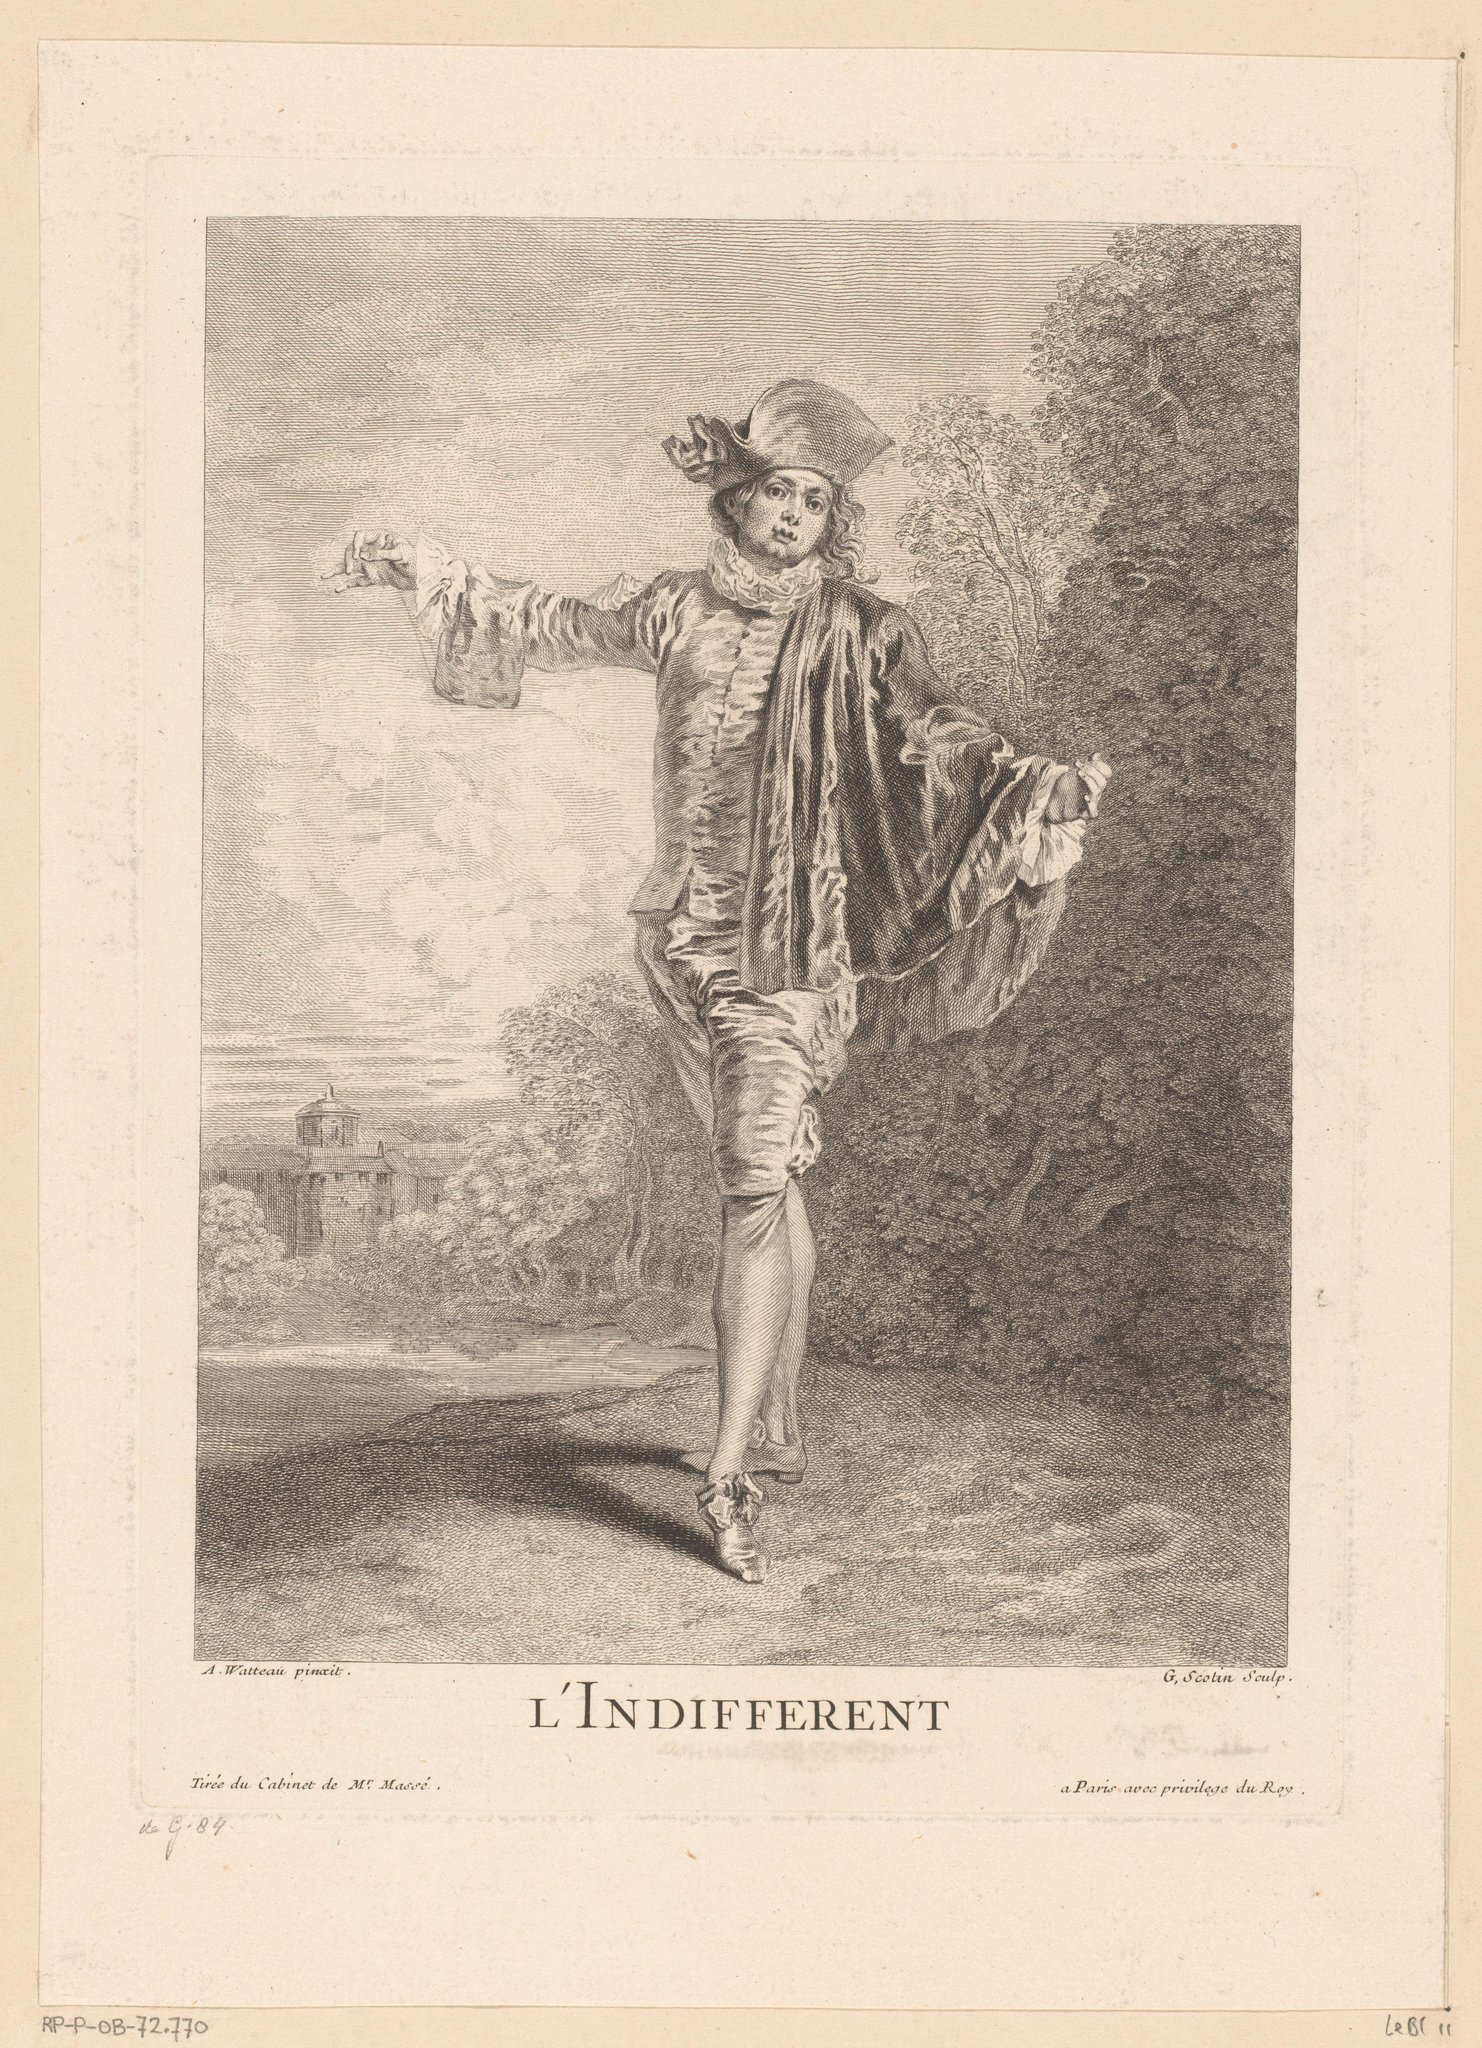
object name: print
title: Theaterfiguur in parklandschap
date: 1729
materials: paper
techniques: engraving, etching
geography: france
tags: man dancing alone, 'commedia dell'arte'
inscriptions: collector's mark: Lugt 2228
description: Maakt deel uit van een serie van 271 platen, inclusief twee titelprenten, naar schilderijen door Watteau en verzameld door Jean de Jullienne. Sommige platen werden reeds tijdens Watteau's leven vervaardigd en de rest kwam pas na zijn dood tot stand. In 1734 werd het eind van de serie aangekondigd.